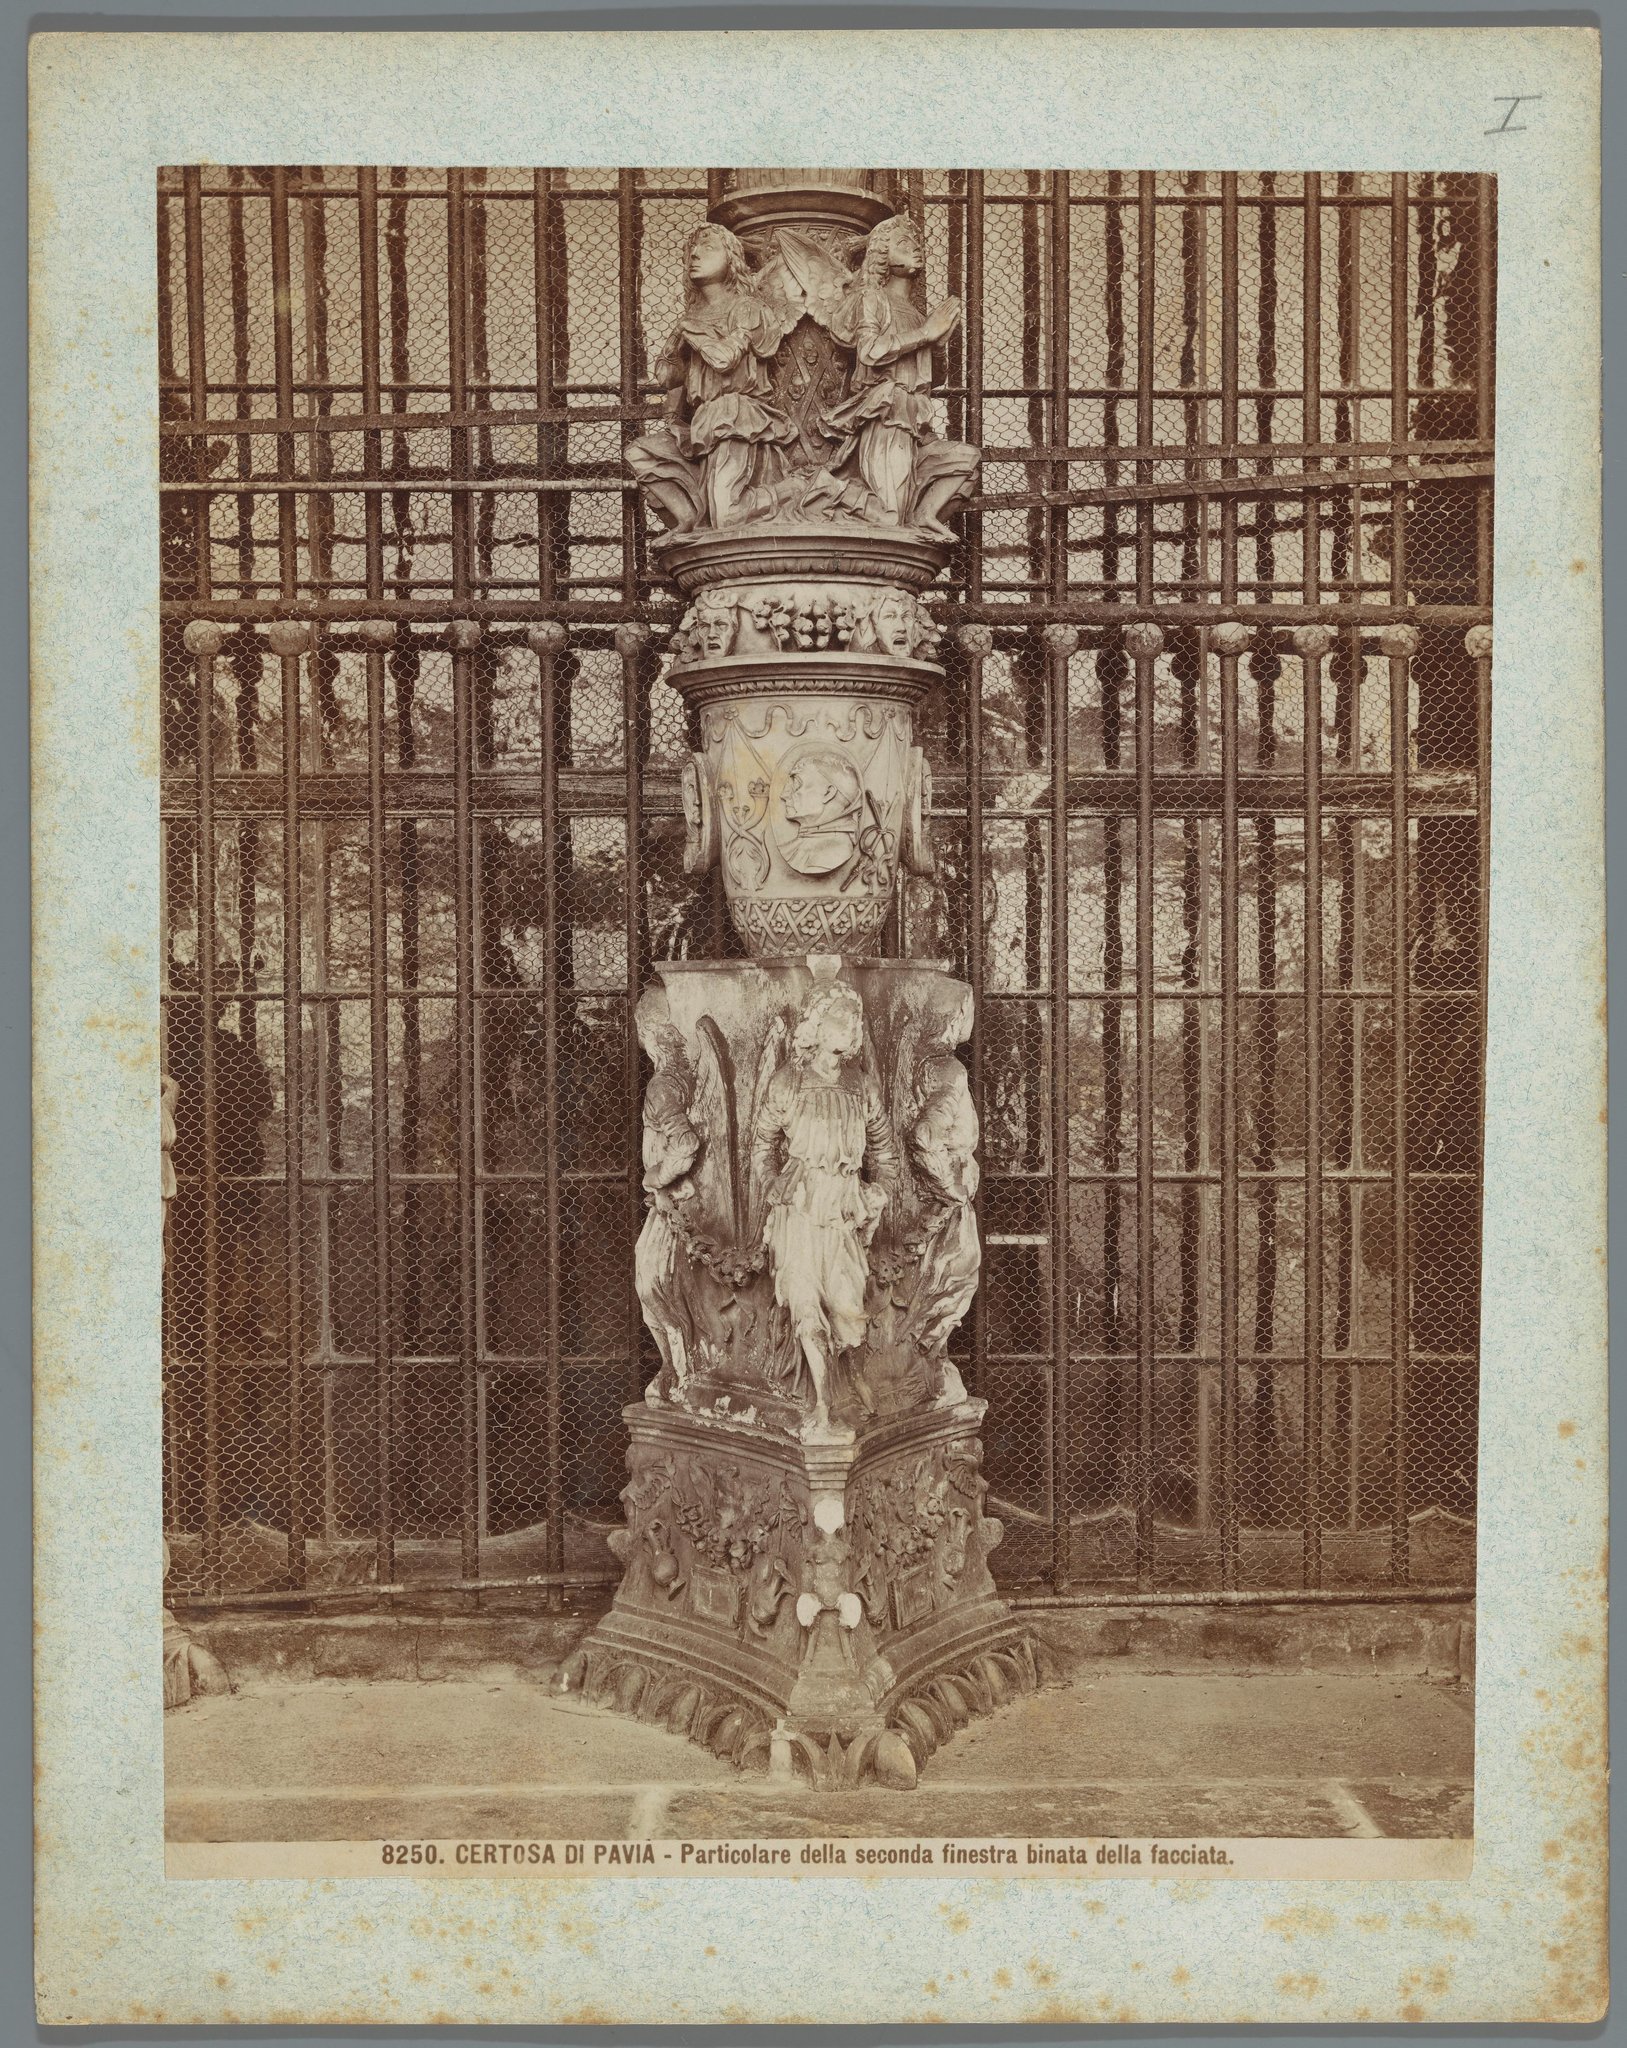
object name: photograph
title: CERTOSA DI PAVIA - Particolare della seconda finestra binata della facciata.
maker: Anonymous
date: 1875-1900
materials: cardboard, photographic support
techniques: albumen print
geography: pavia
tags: church-window, e.g. rose-window, church (exterior), angels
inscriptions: collector's mark: Lugt 3937, number: ‘8250.’